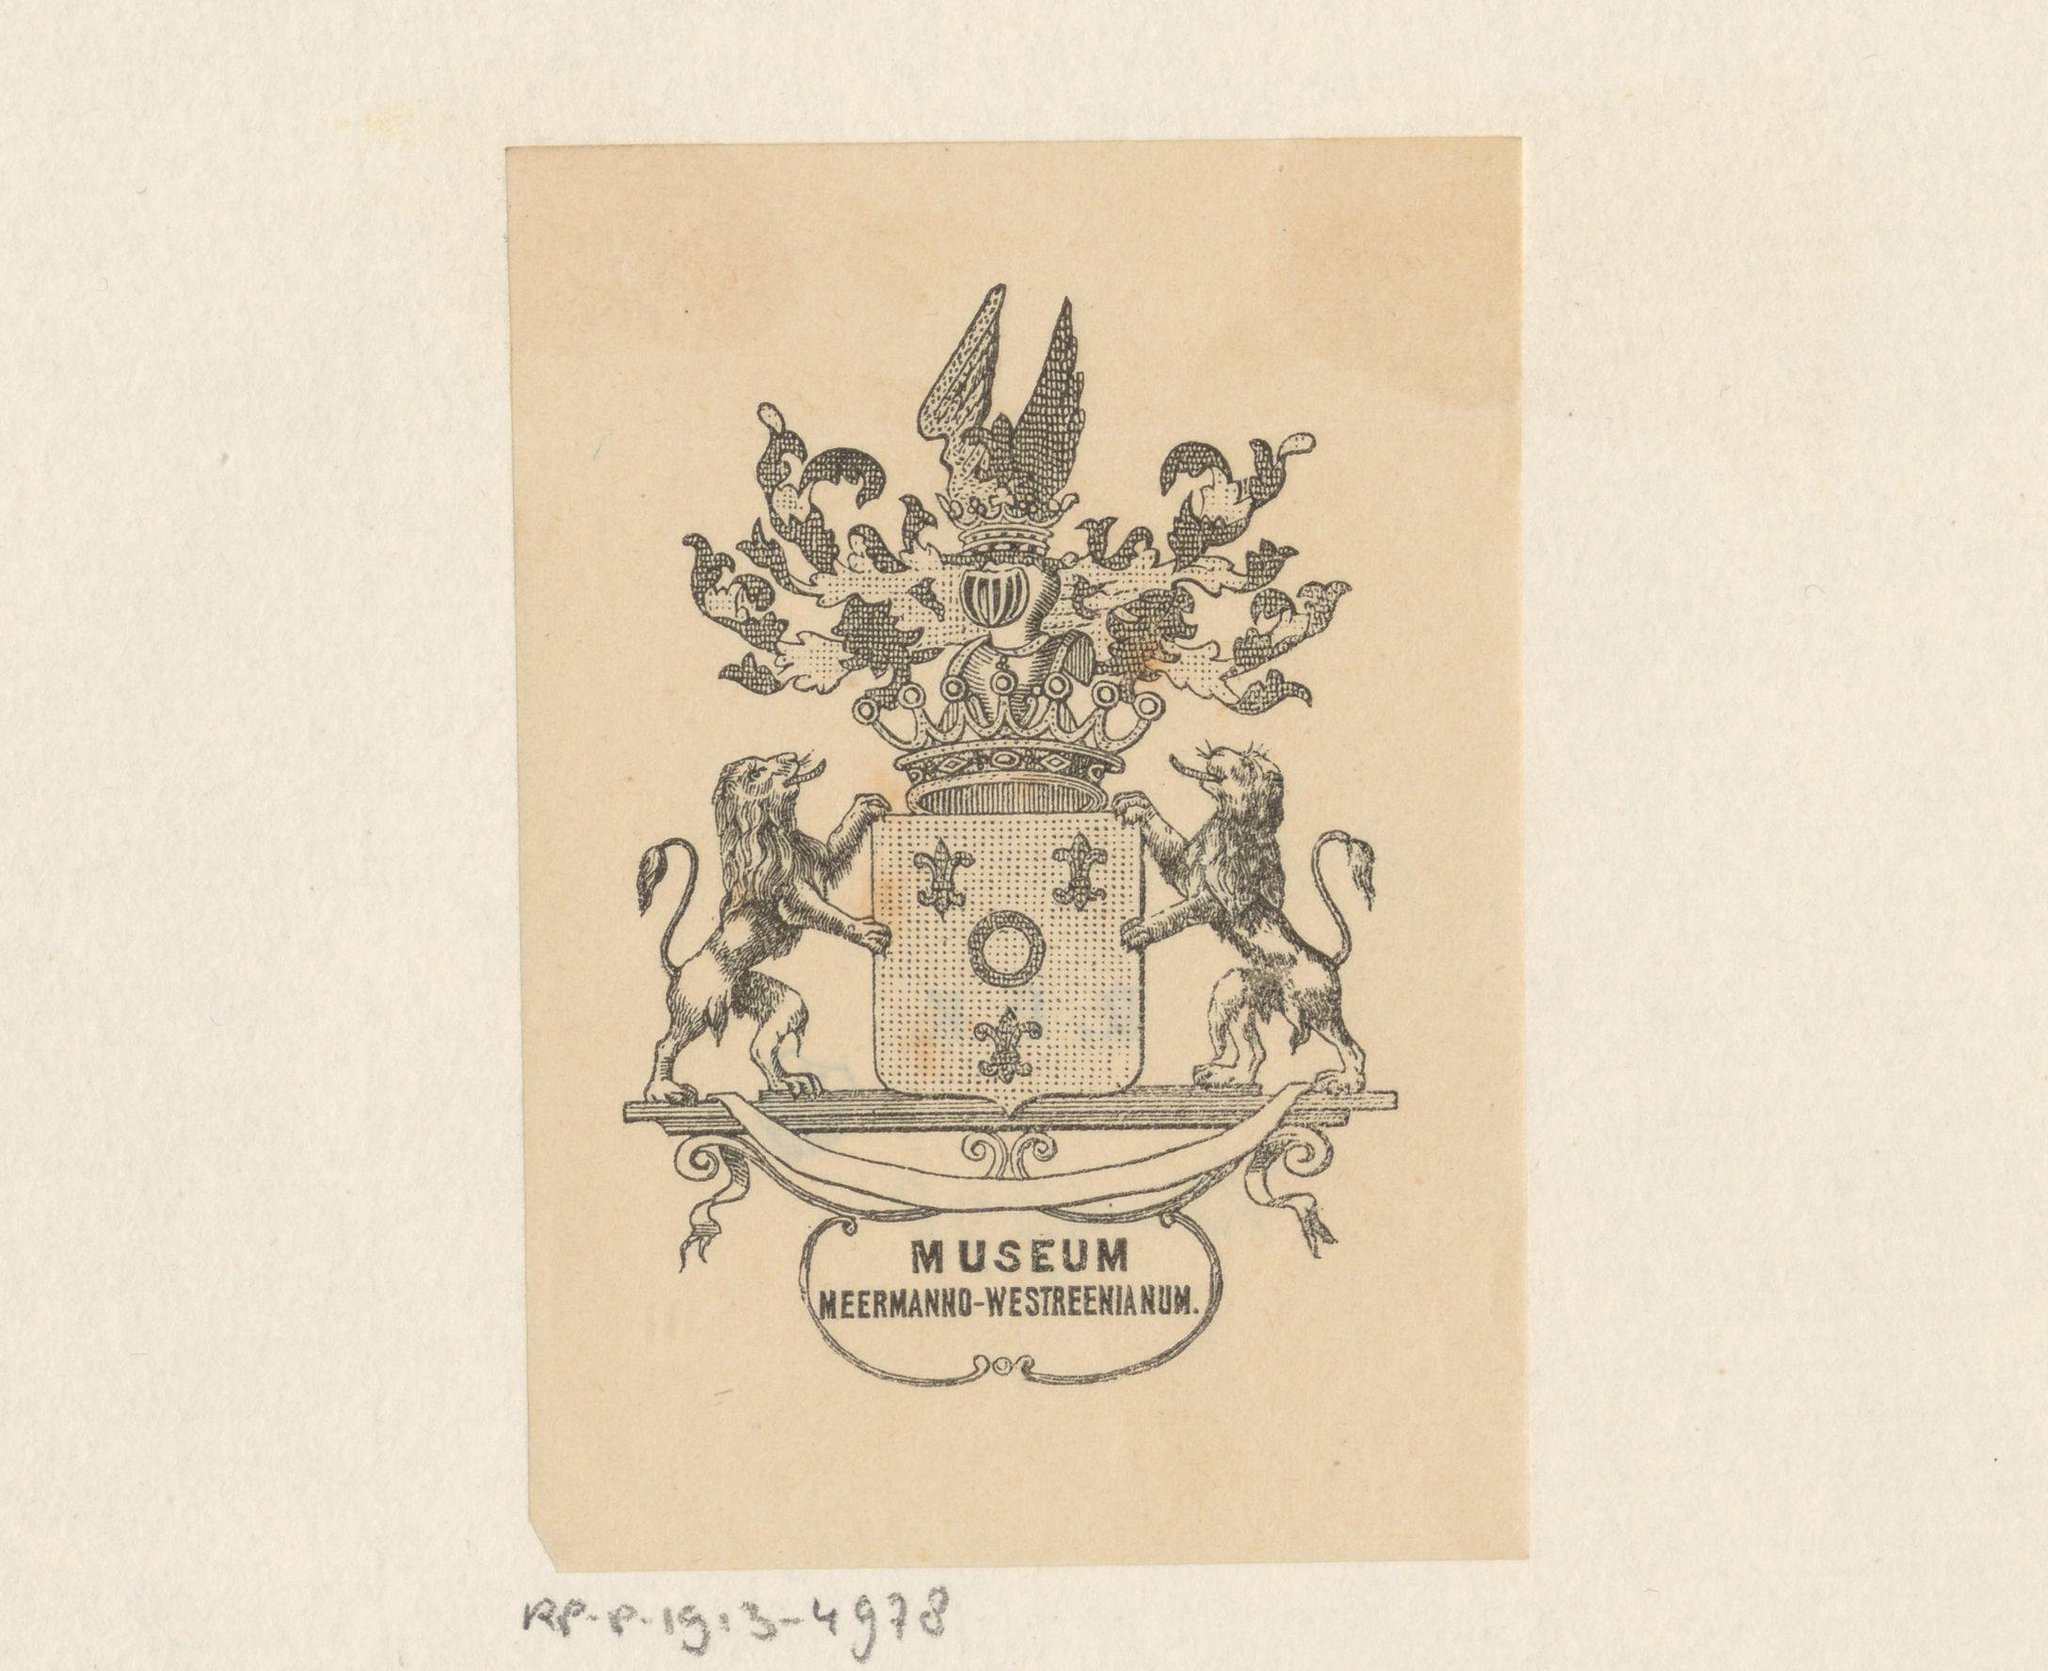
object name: bookplate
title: Ex libris van Museum Meermanno-Westreenianum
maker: Anonymous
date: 1852-1913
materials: paper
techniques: printing block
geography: netherlands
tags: beasts of prey, predatory animals: lion, armorial bearing, heraldry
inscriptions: collector's mark: Lugt 2760, collector's mark: Lugt 2233